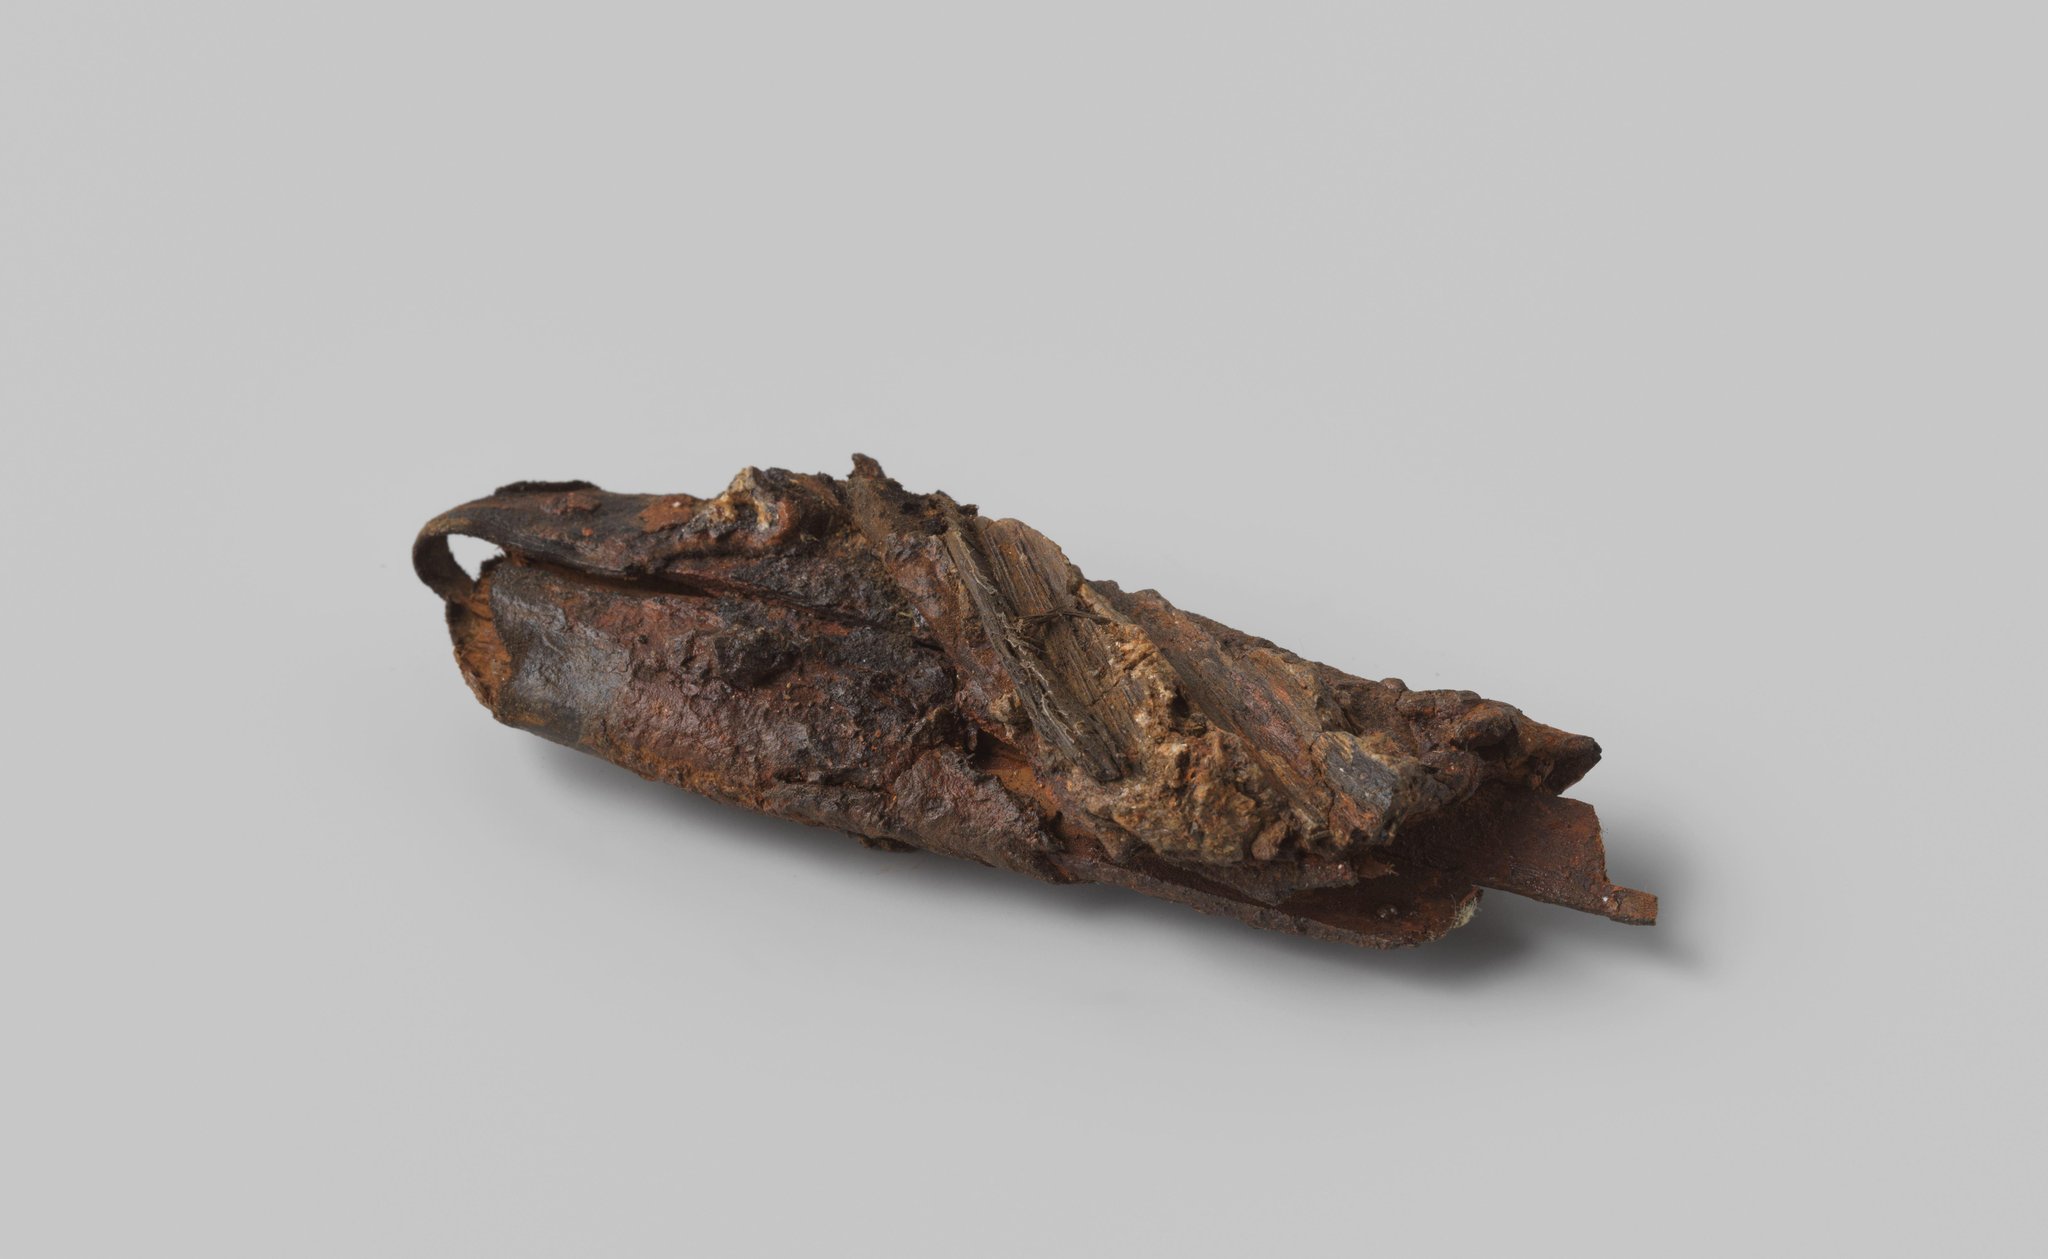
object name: knife with sheath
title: Schede uit het wrak van de Oost-Indiëvaarder Hollandia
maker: Anonymous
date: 1700-1743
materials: leather, wood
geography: netherlands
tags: verenigde oostindische compagnie, hollandia (schip), annet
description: Scabbard; fragm, both ends broken, straight, remains of leather cover, with longitudinal seam.